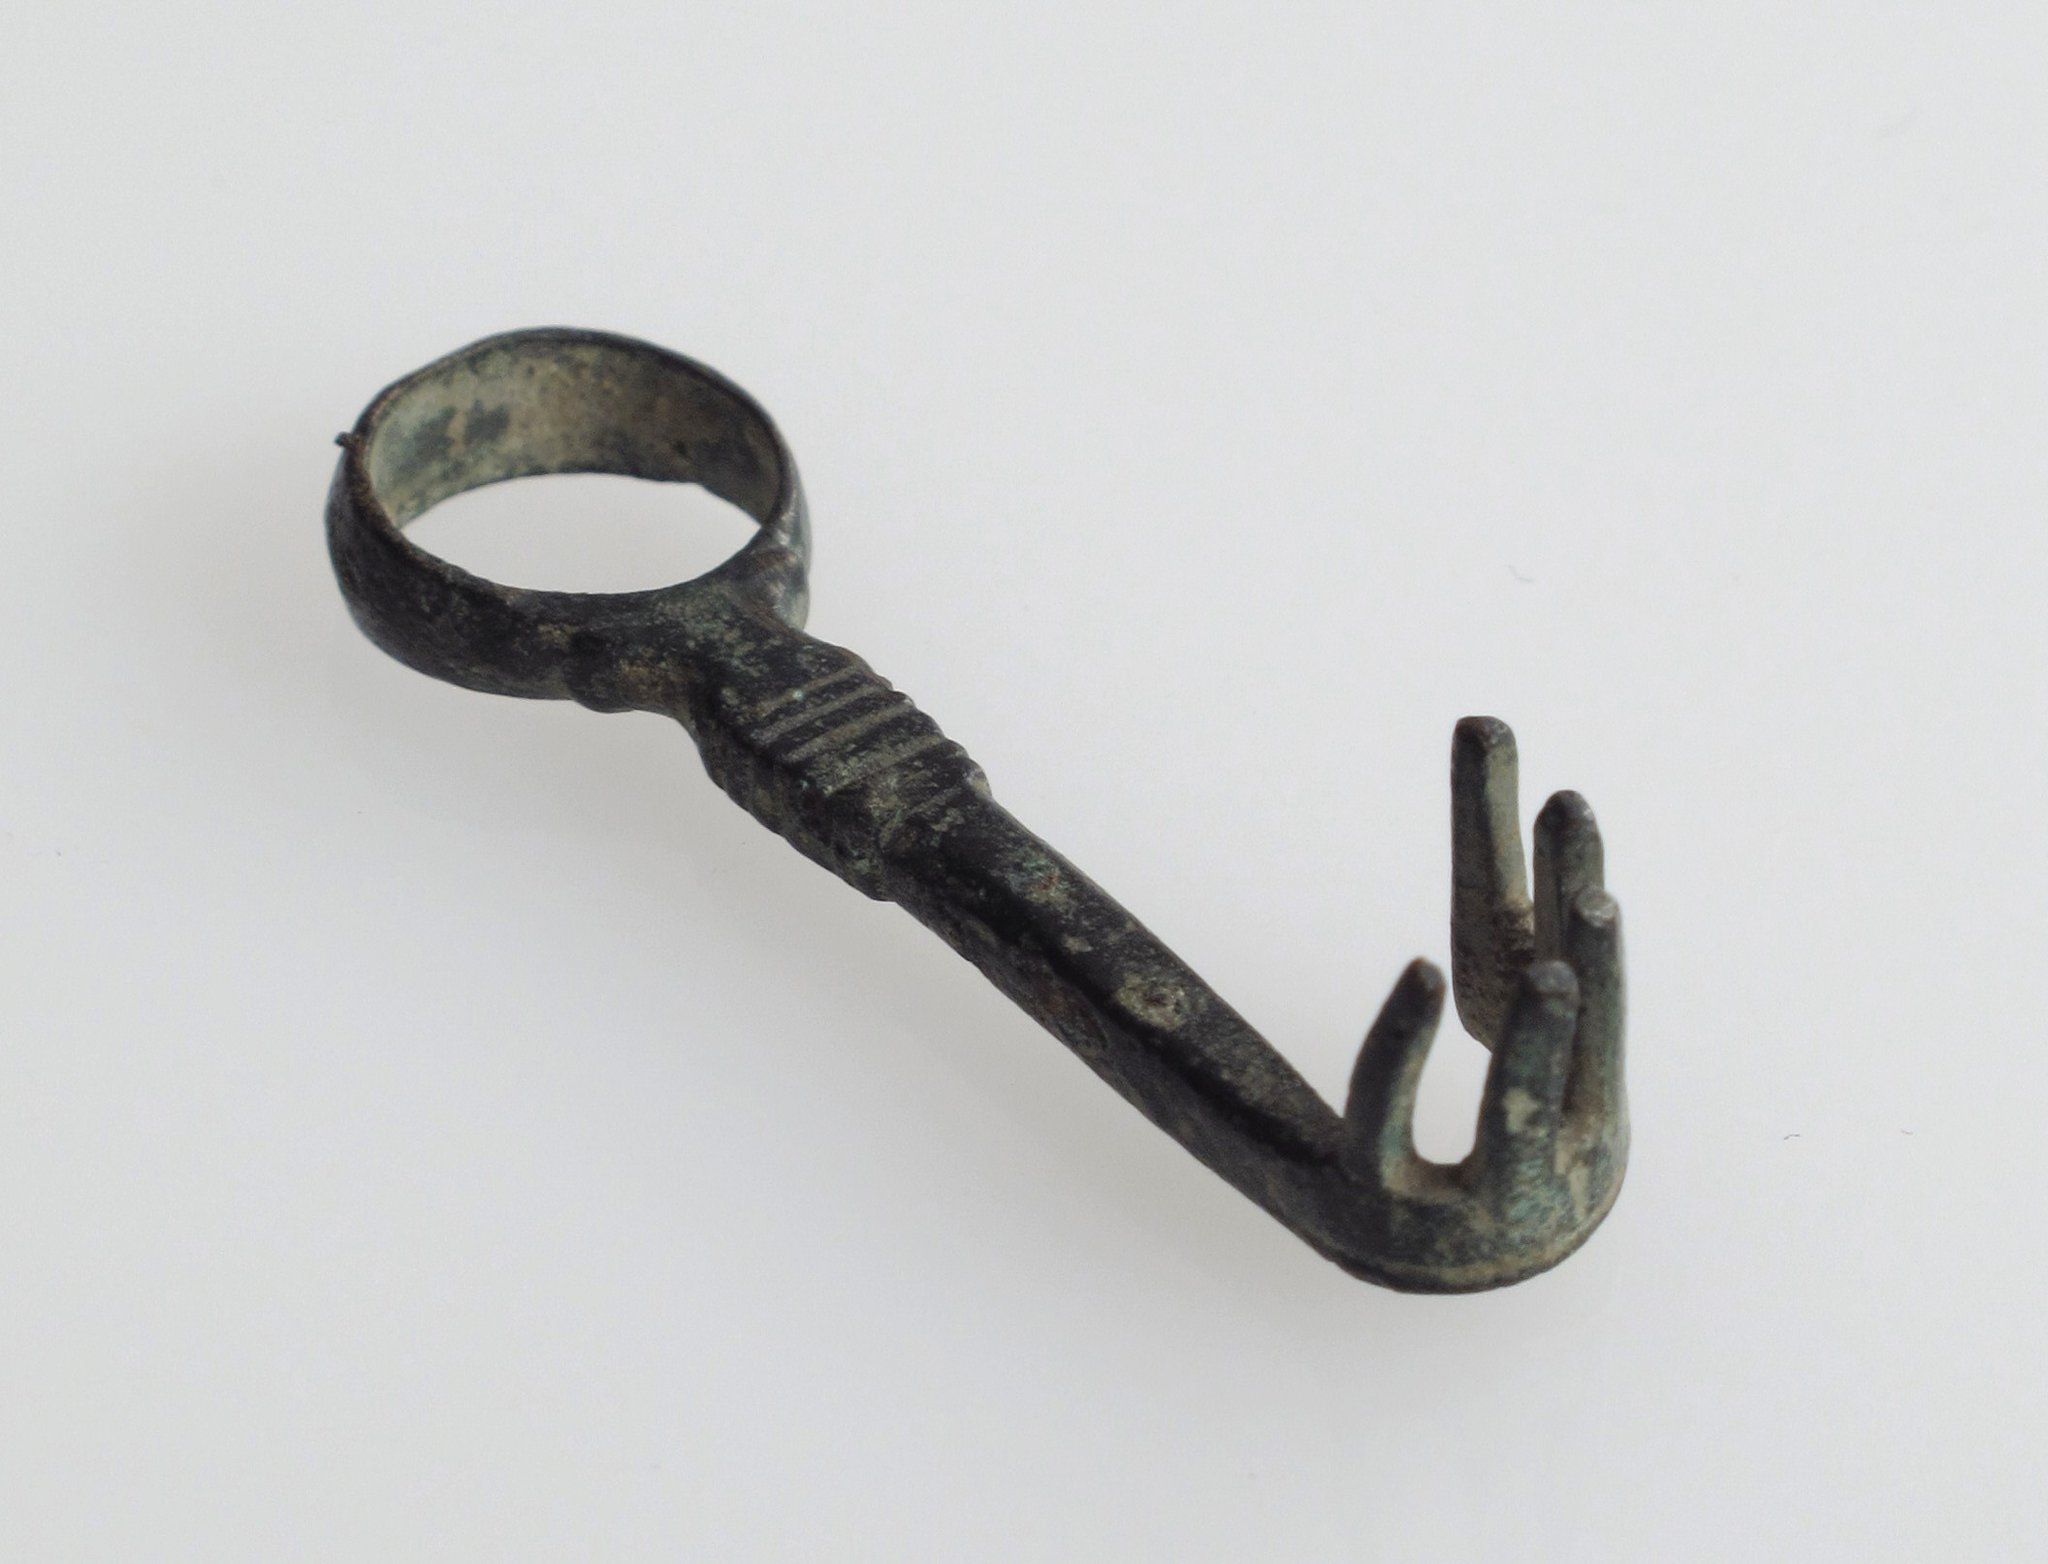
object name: key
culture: roman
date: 1-700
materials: copper alloy